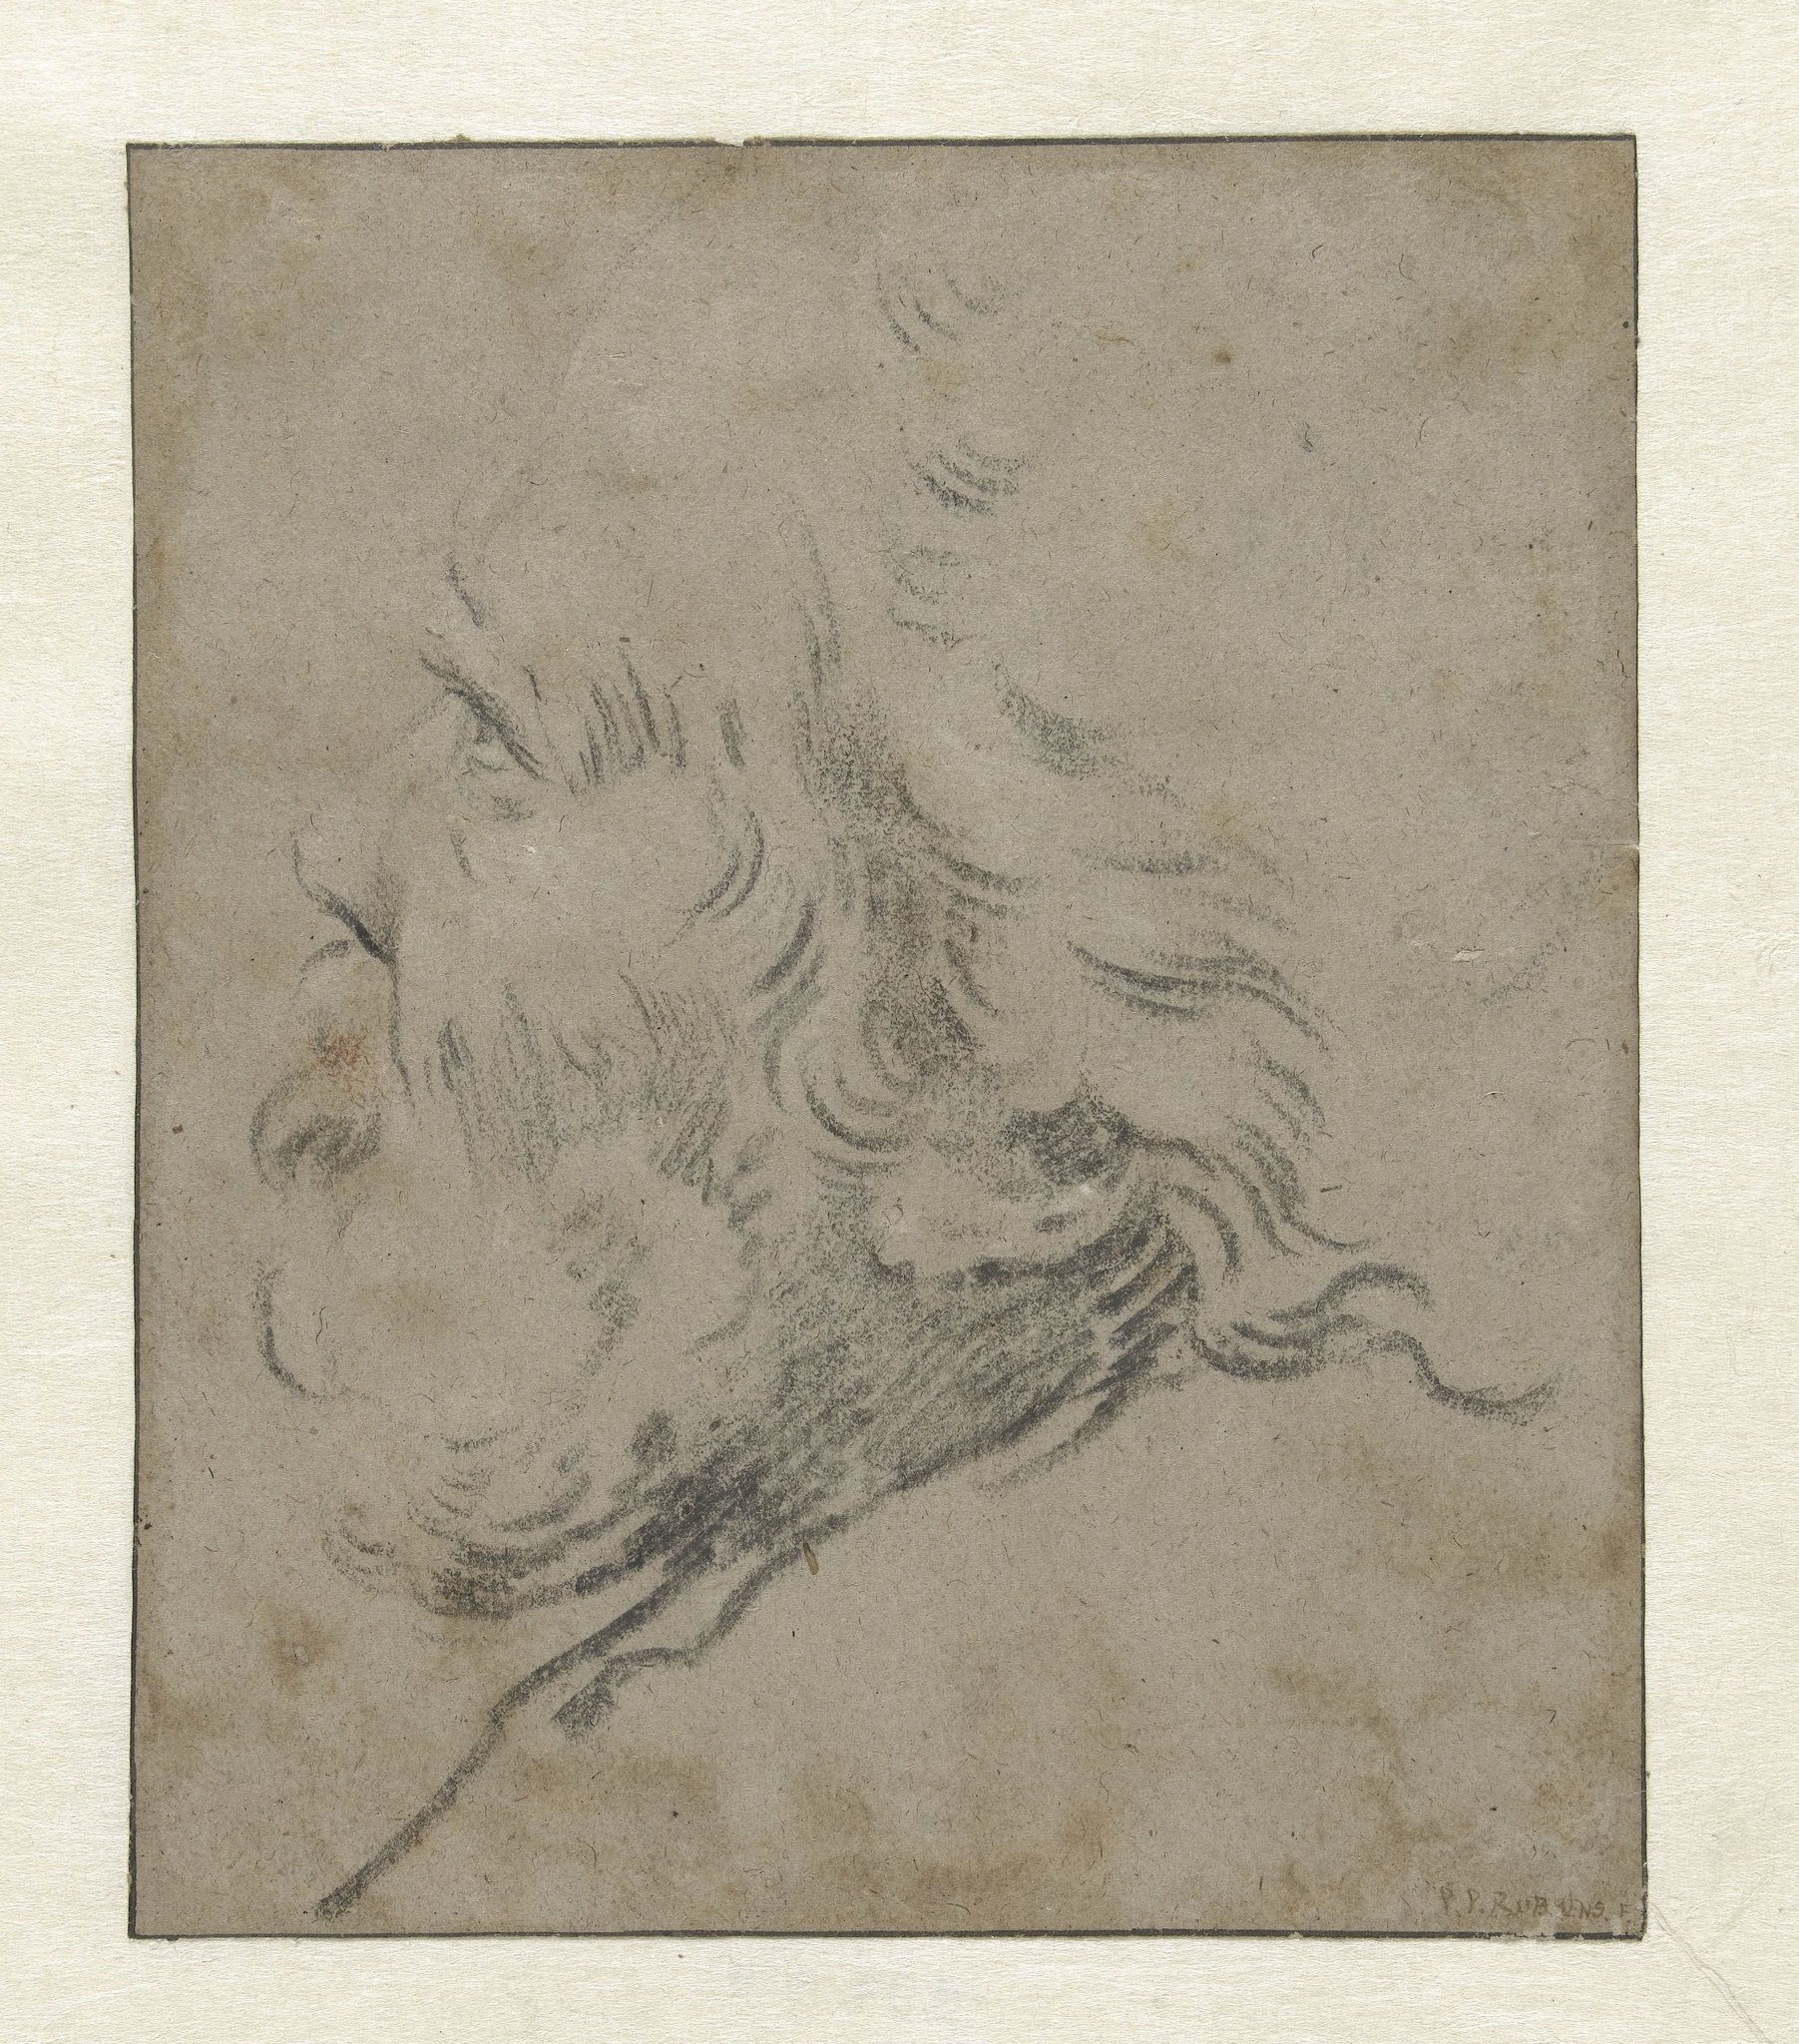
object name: drawing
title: Kop van een oude man, in profiel naar links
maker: gaspar de crayer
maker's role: draughtsman, print maker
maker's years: 1584-1669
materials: chalk, paper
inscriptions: inscription: ‘rechtsonder : "PP Rubens F."’